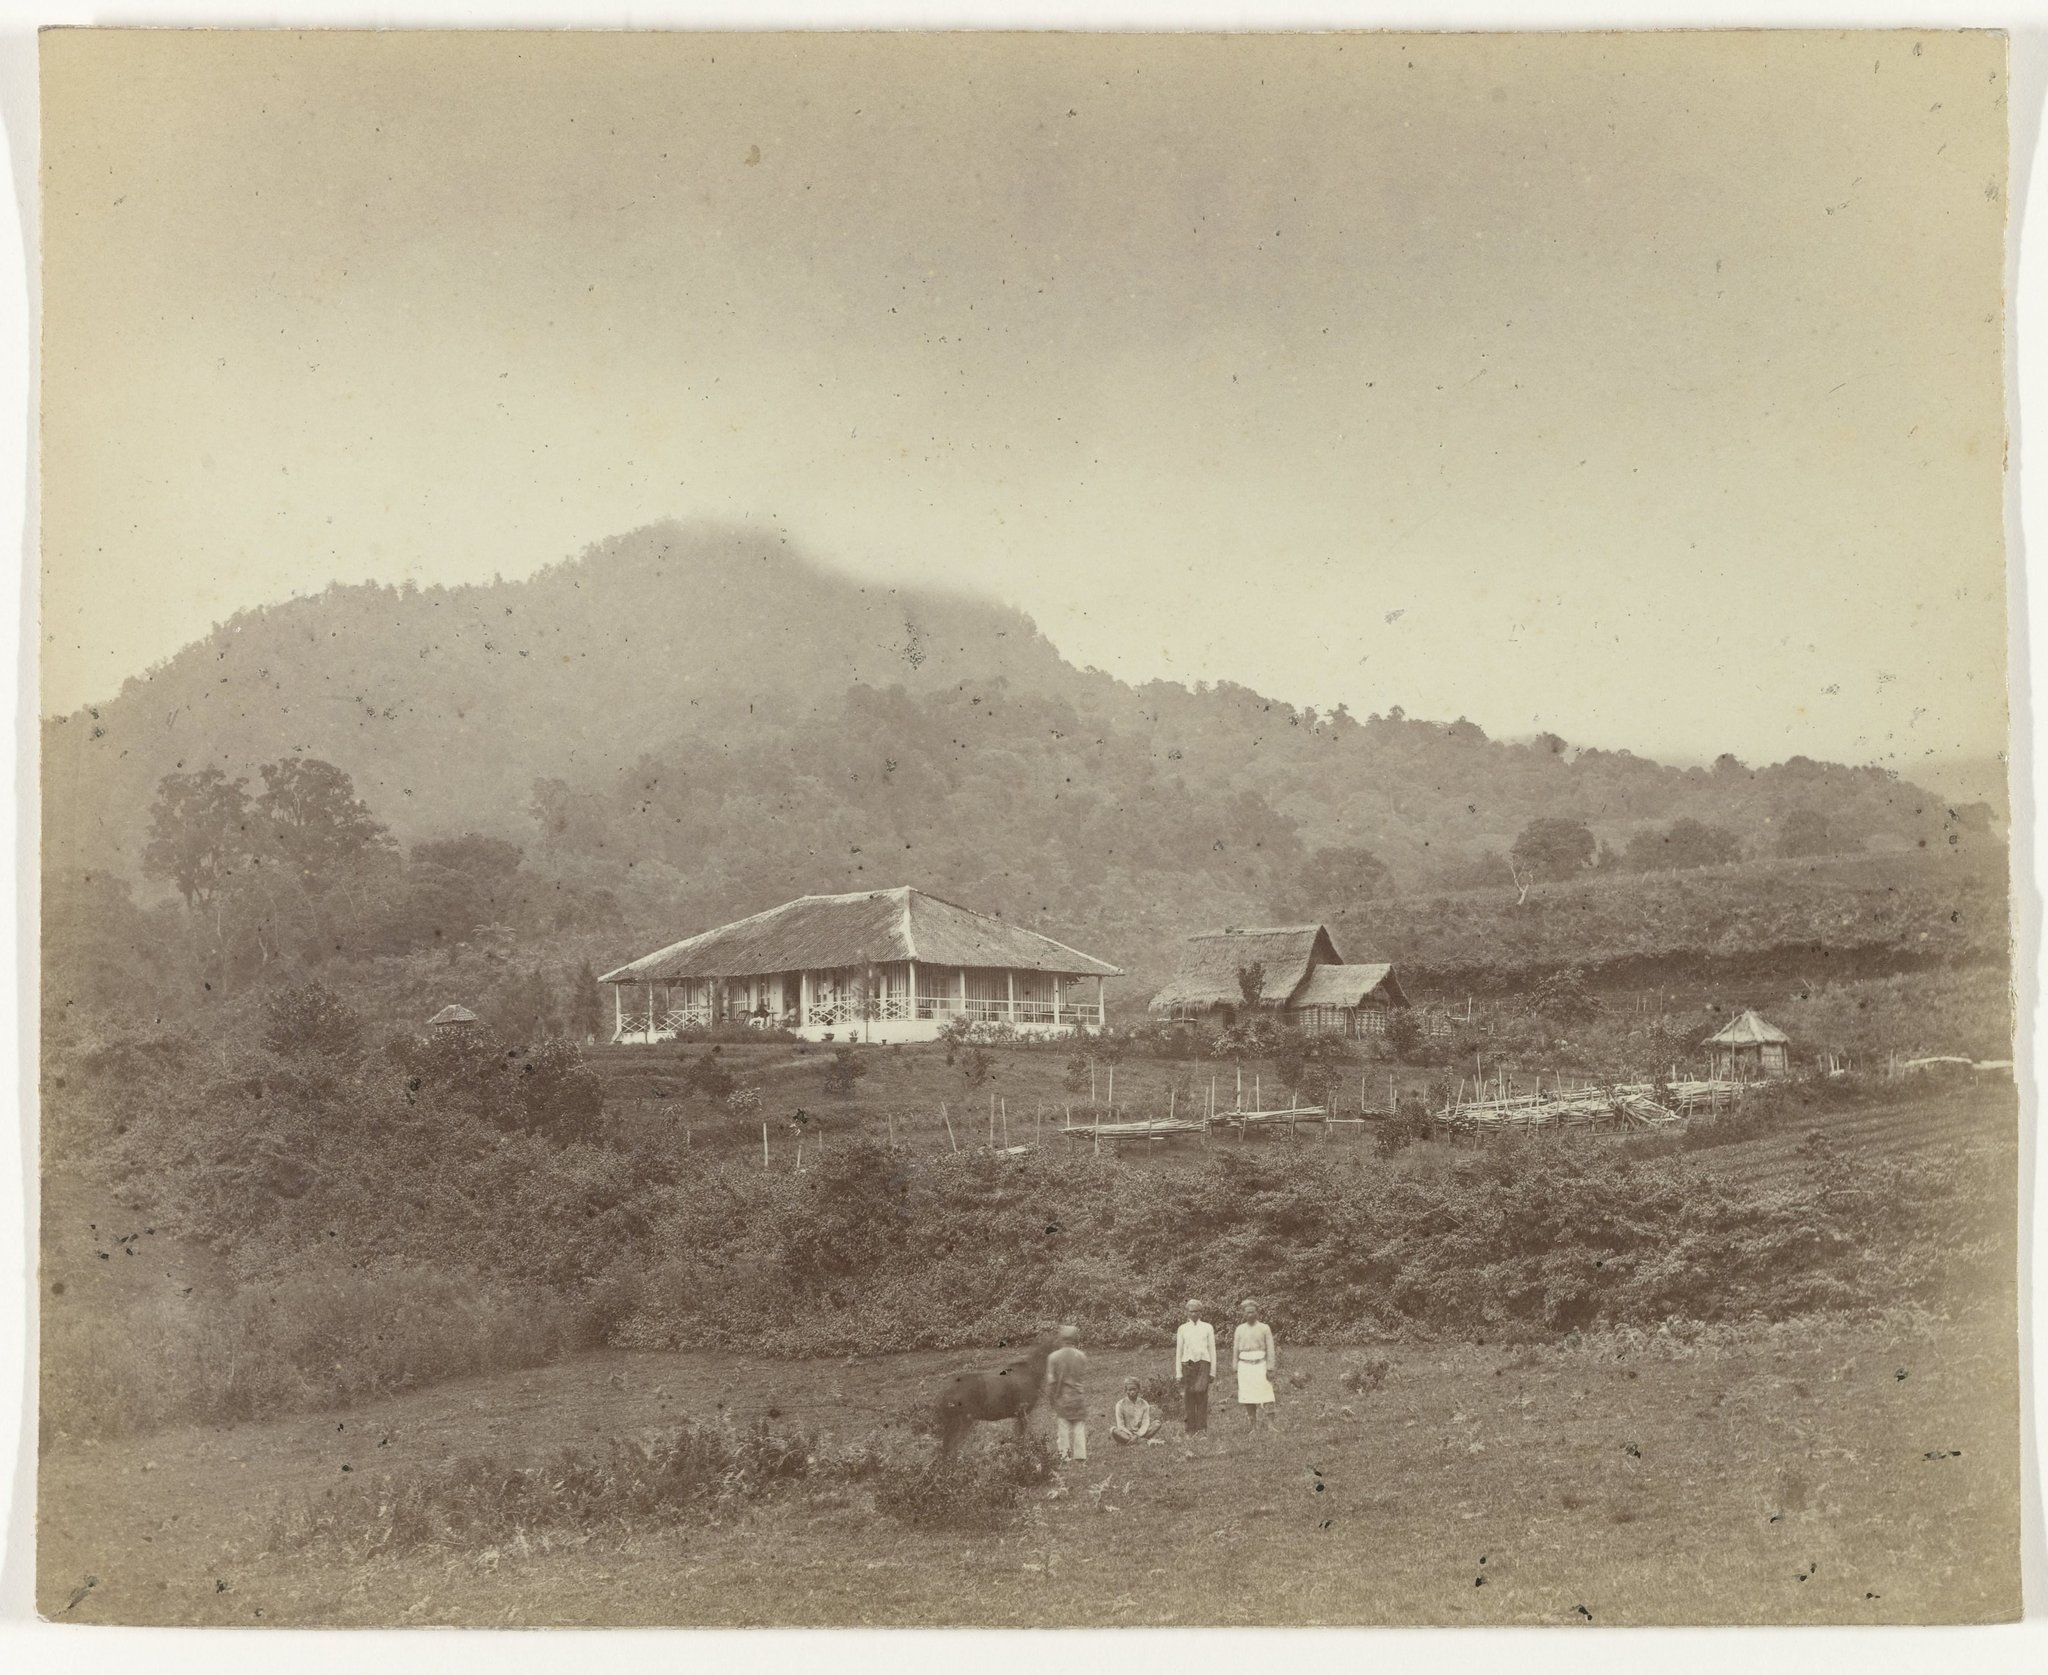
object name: photograph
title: Staatsspoorwegen op Java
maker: Anonymous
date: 1880-1888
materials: photographic support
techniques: albumen print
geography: ardjoeno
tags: ardjoeno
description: Gezicht van Djoengo (Koffu land) in het Ardjoengebergte. Onderdeel van een groep van 62 foto's in een doos met het opschrift "Staatsspoorwegen op Java" uit 1888.